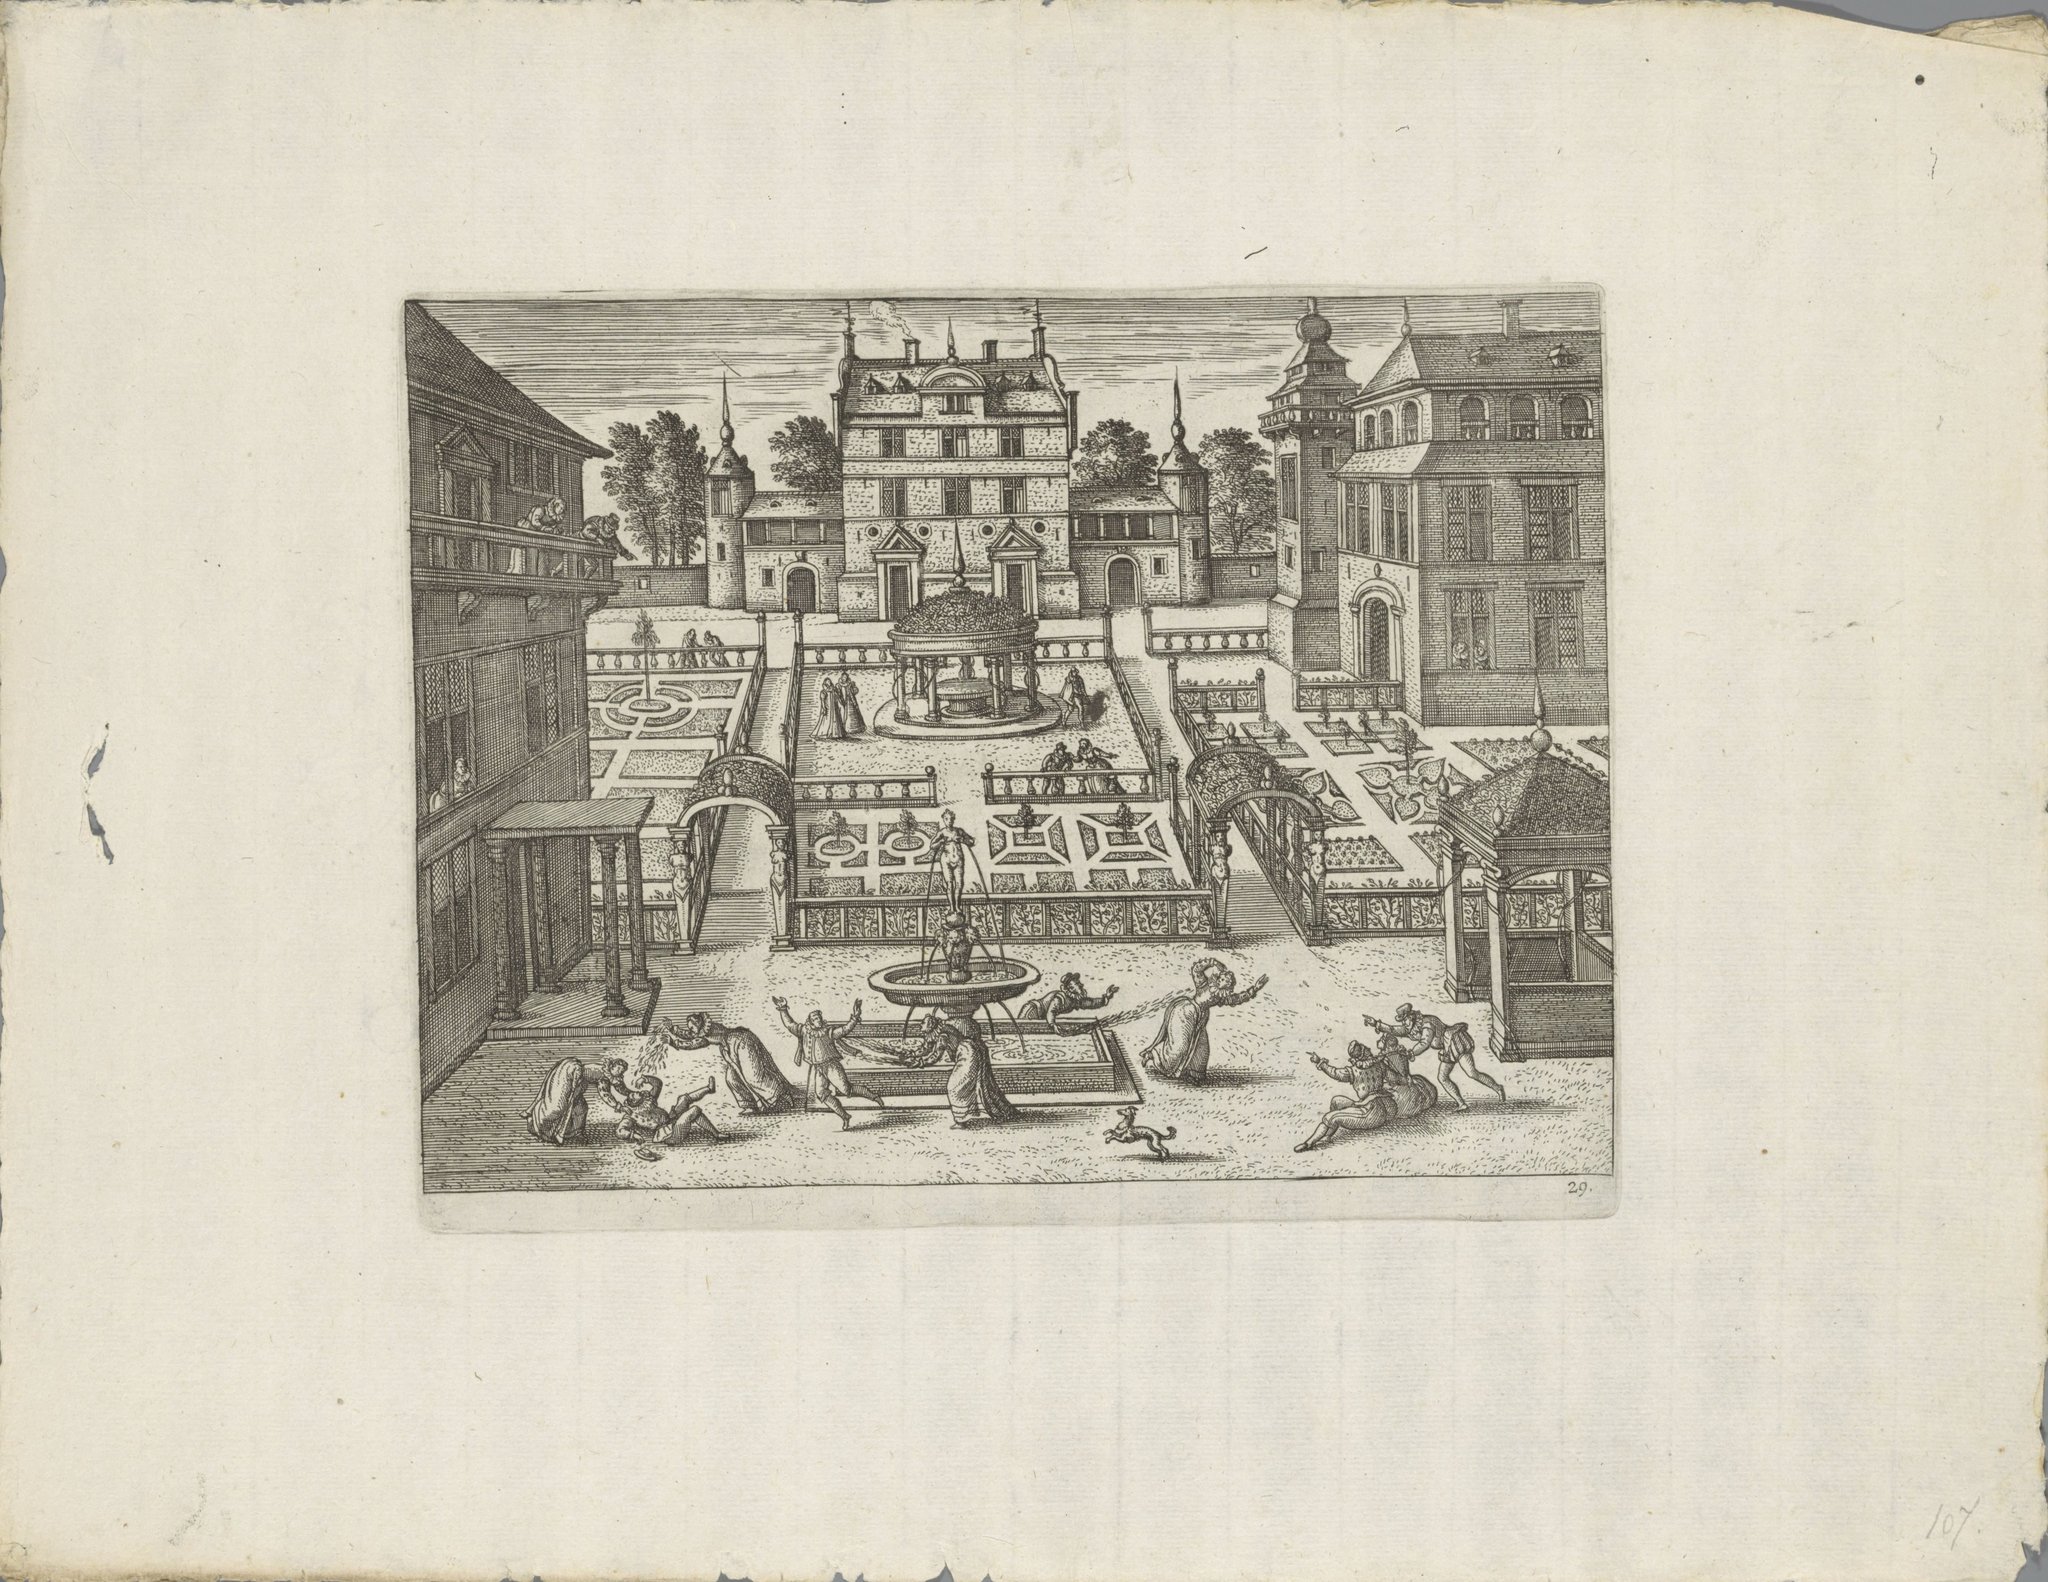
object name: print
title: Tuinen der Minne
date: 1545-1608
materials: paper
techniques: etching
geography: antwerp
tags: garden, garden fountain, french or architectonic garden; formal garden, garden of love, court of love, 'fête galante', dog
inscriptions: collector's mark: Lugt 2228, collector's mark: Lugt 2760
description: De serie ‘Hortorum Viridariorumque’ van Vredeman de Vries (Hollstein Dutch 470-490) is in deze editie van de serie door uitgever Joannes Galle ( en eerder door zijn voorganger Theodoor Galle) aangevuld met de serie ‘Tuinen’ van Vredeman de Vries (Hollstein Dutch 508-515) en met twee prenten van Pieter van der Borcht (I) (New Hollstein Dutch 161-162). De prenten zijn genummerd: 1-30. Origineel hoort bij deze editie van de serie, uitgegeven door Joannes Galle, nog een prent van Van der Borcht met nummer 31, maar deze prent ontbreekt in deze serie in de collectie van het Rijksmuseum.